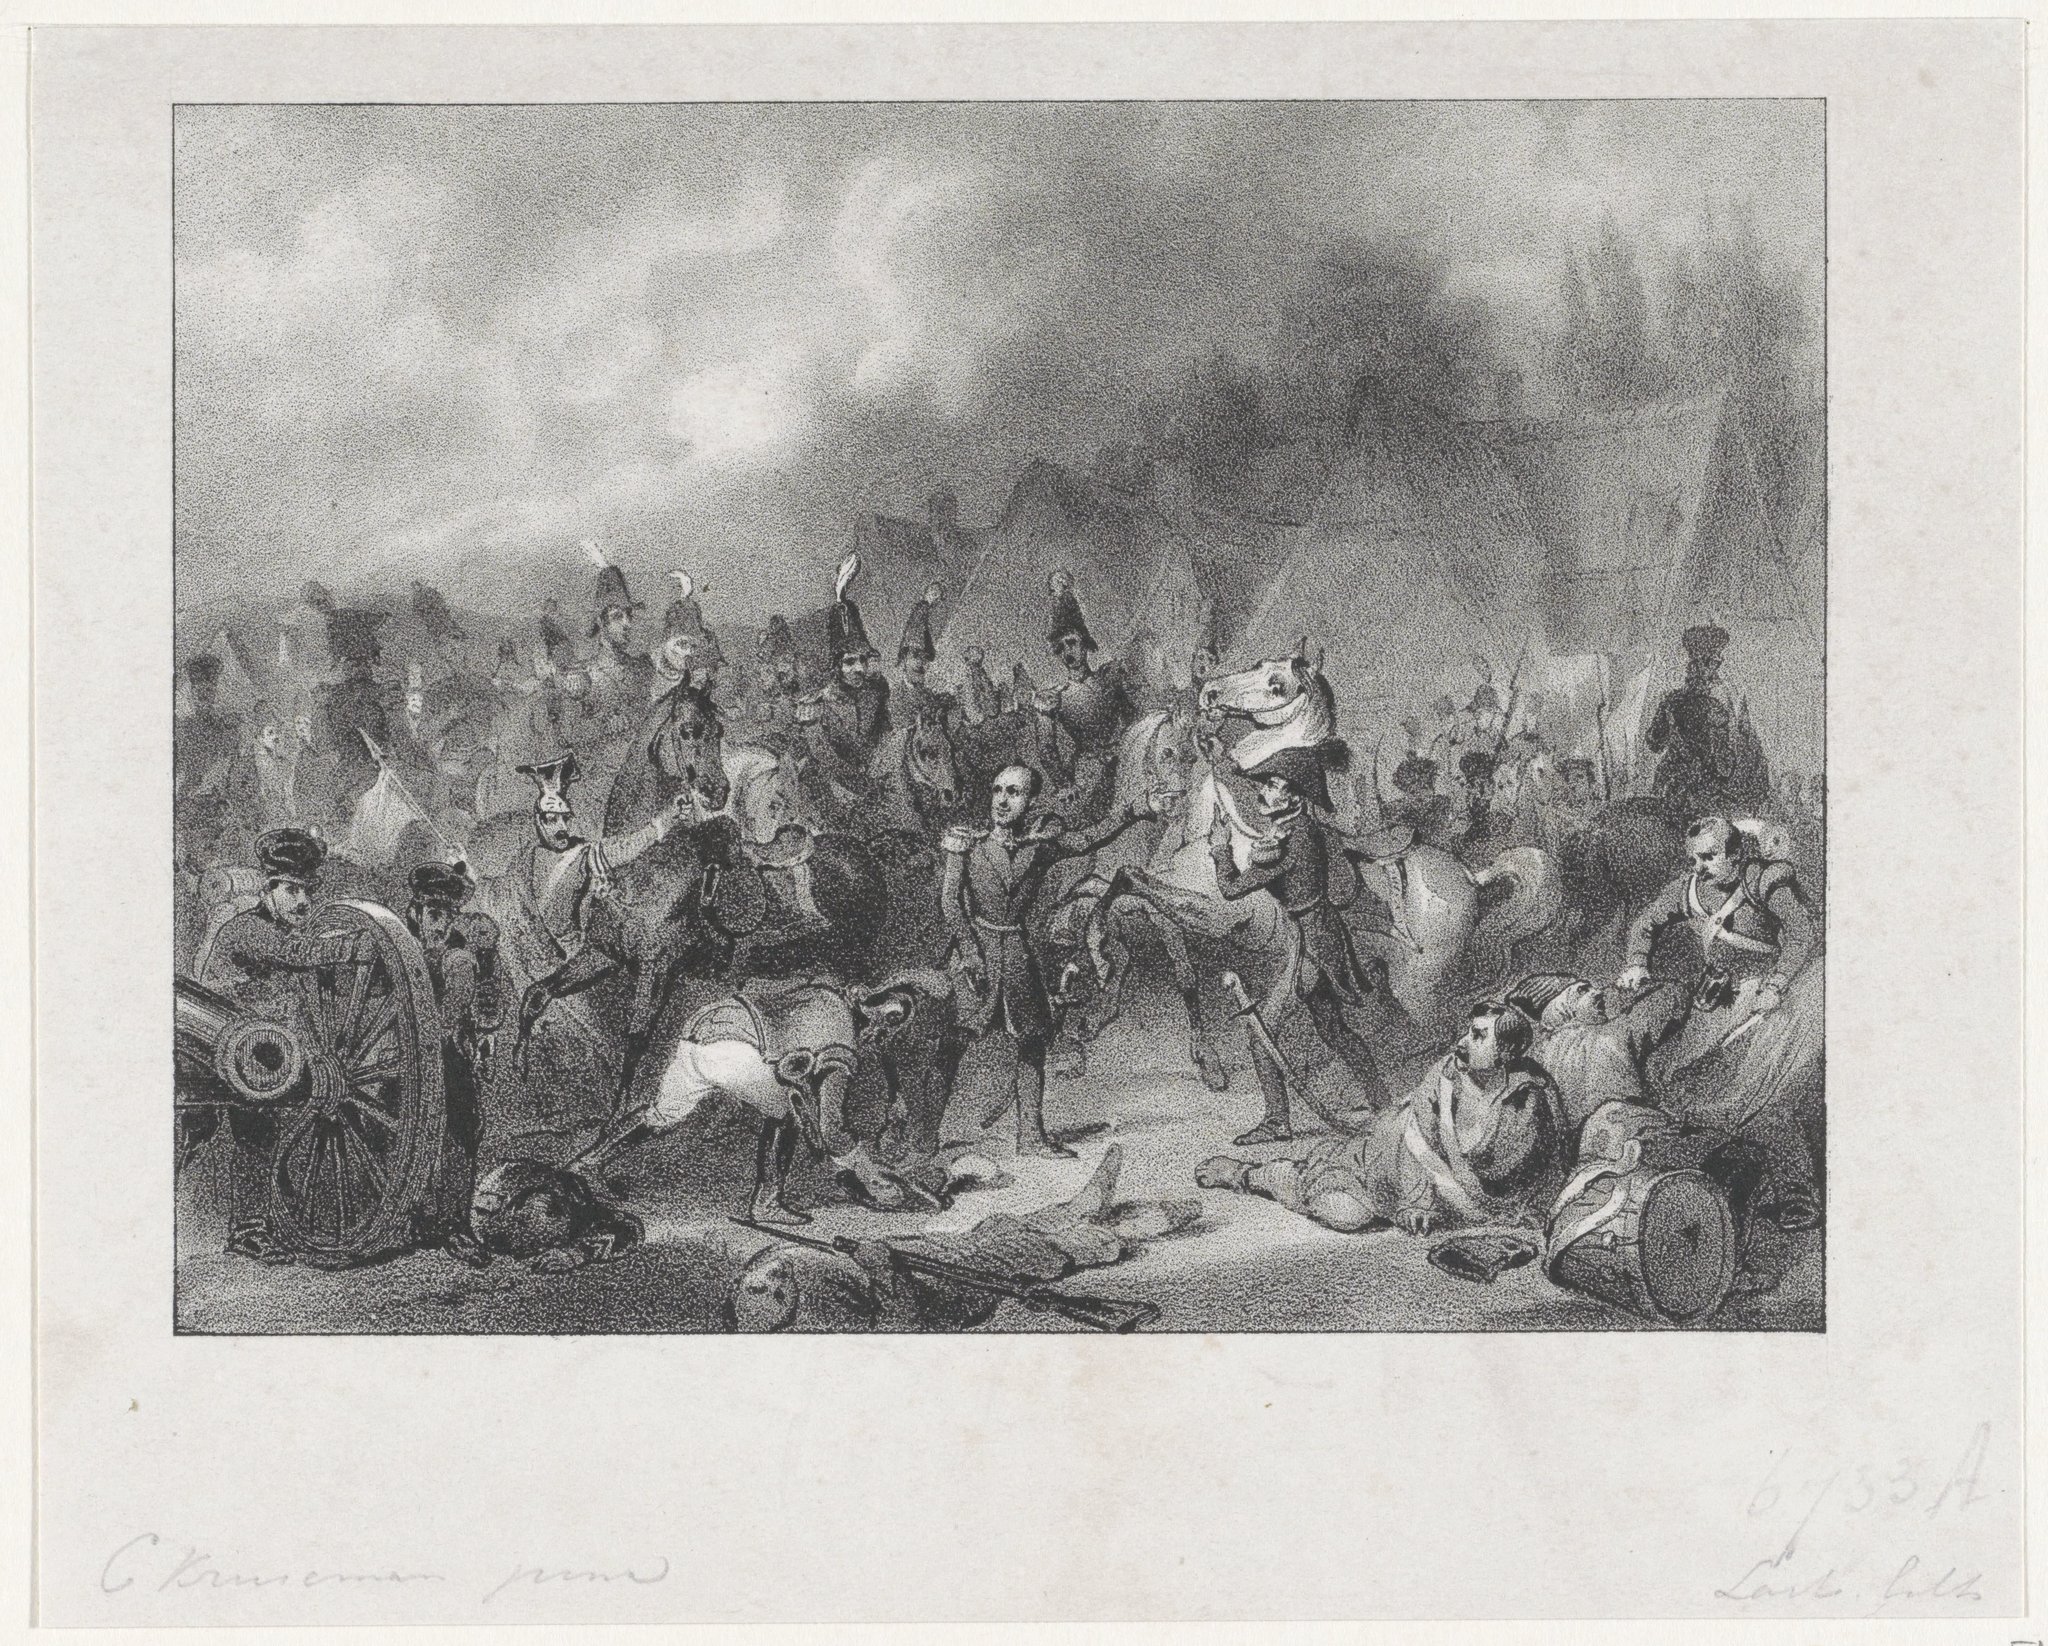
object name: print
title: Overwinning in de slag bij Boutersem, 1831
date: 1831-1840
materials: paper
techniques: lithograph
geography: netherlands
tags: william ii of the netherlands, berlin, frederik (prins der nederlanden), fighting horses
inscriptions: collector's mark: Lugt 2166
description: Overwinning in de slag bij Boutersem, 12 augustus 1831. Centraal staande op de grond de prins van Oranje die zijn paard waarvan een deel van been is afgeschoten verruilt voor een ander paard hem aangereikt door majoor Hoyel. Achter de prins zijn broer Frederik en zijn staf te paard. Links een kanon, op de voorgrond en rechts doden en gewonden.